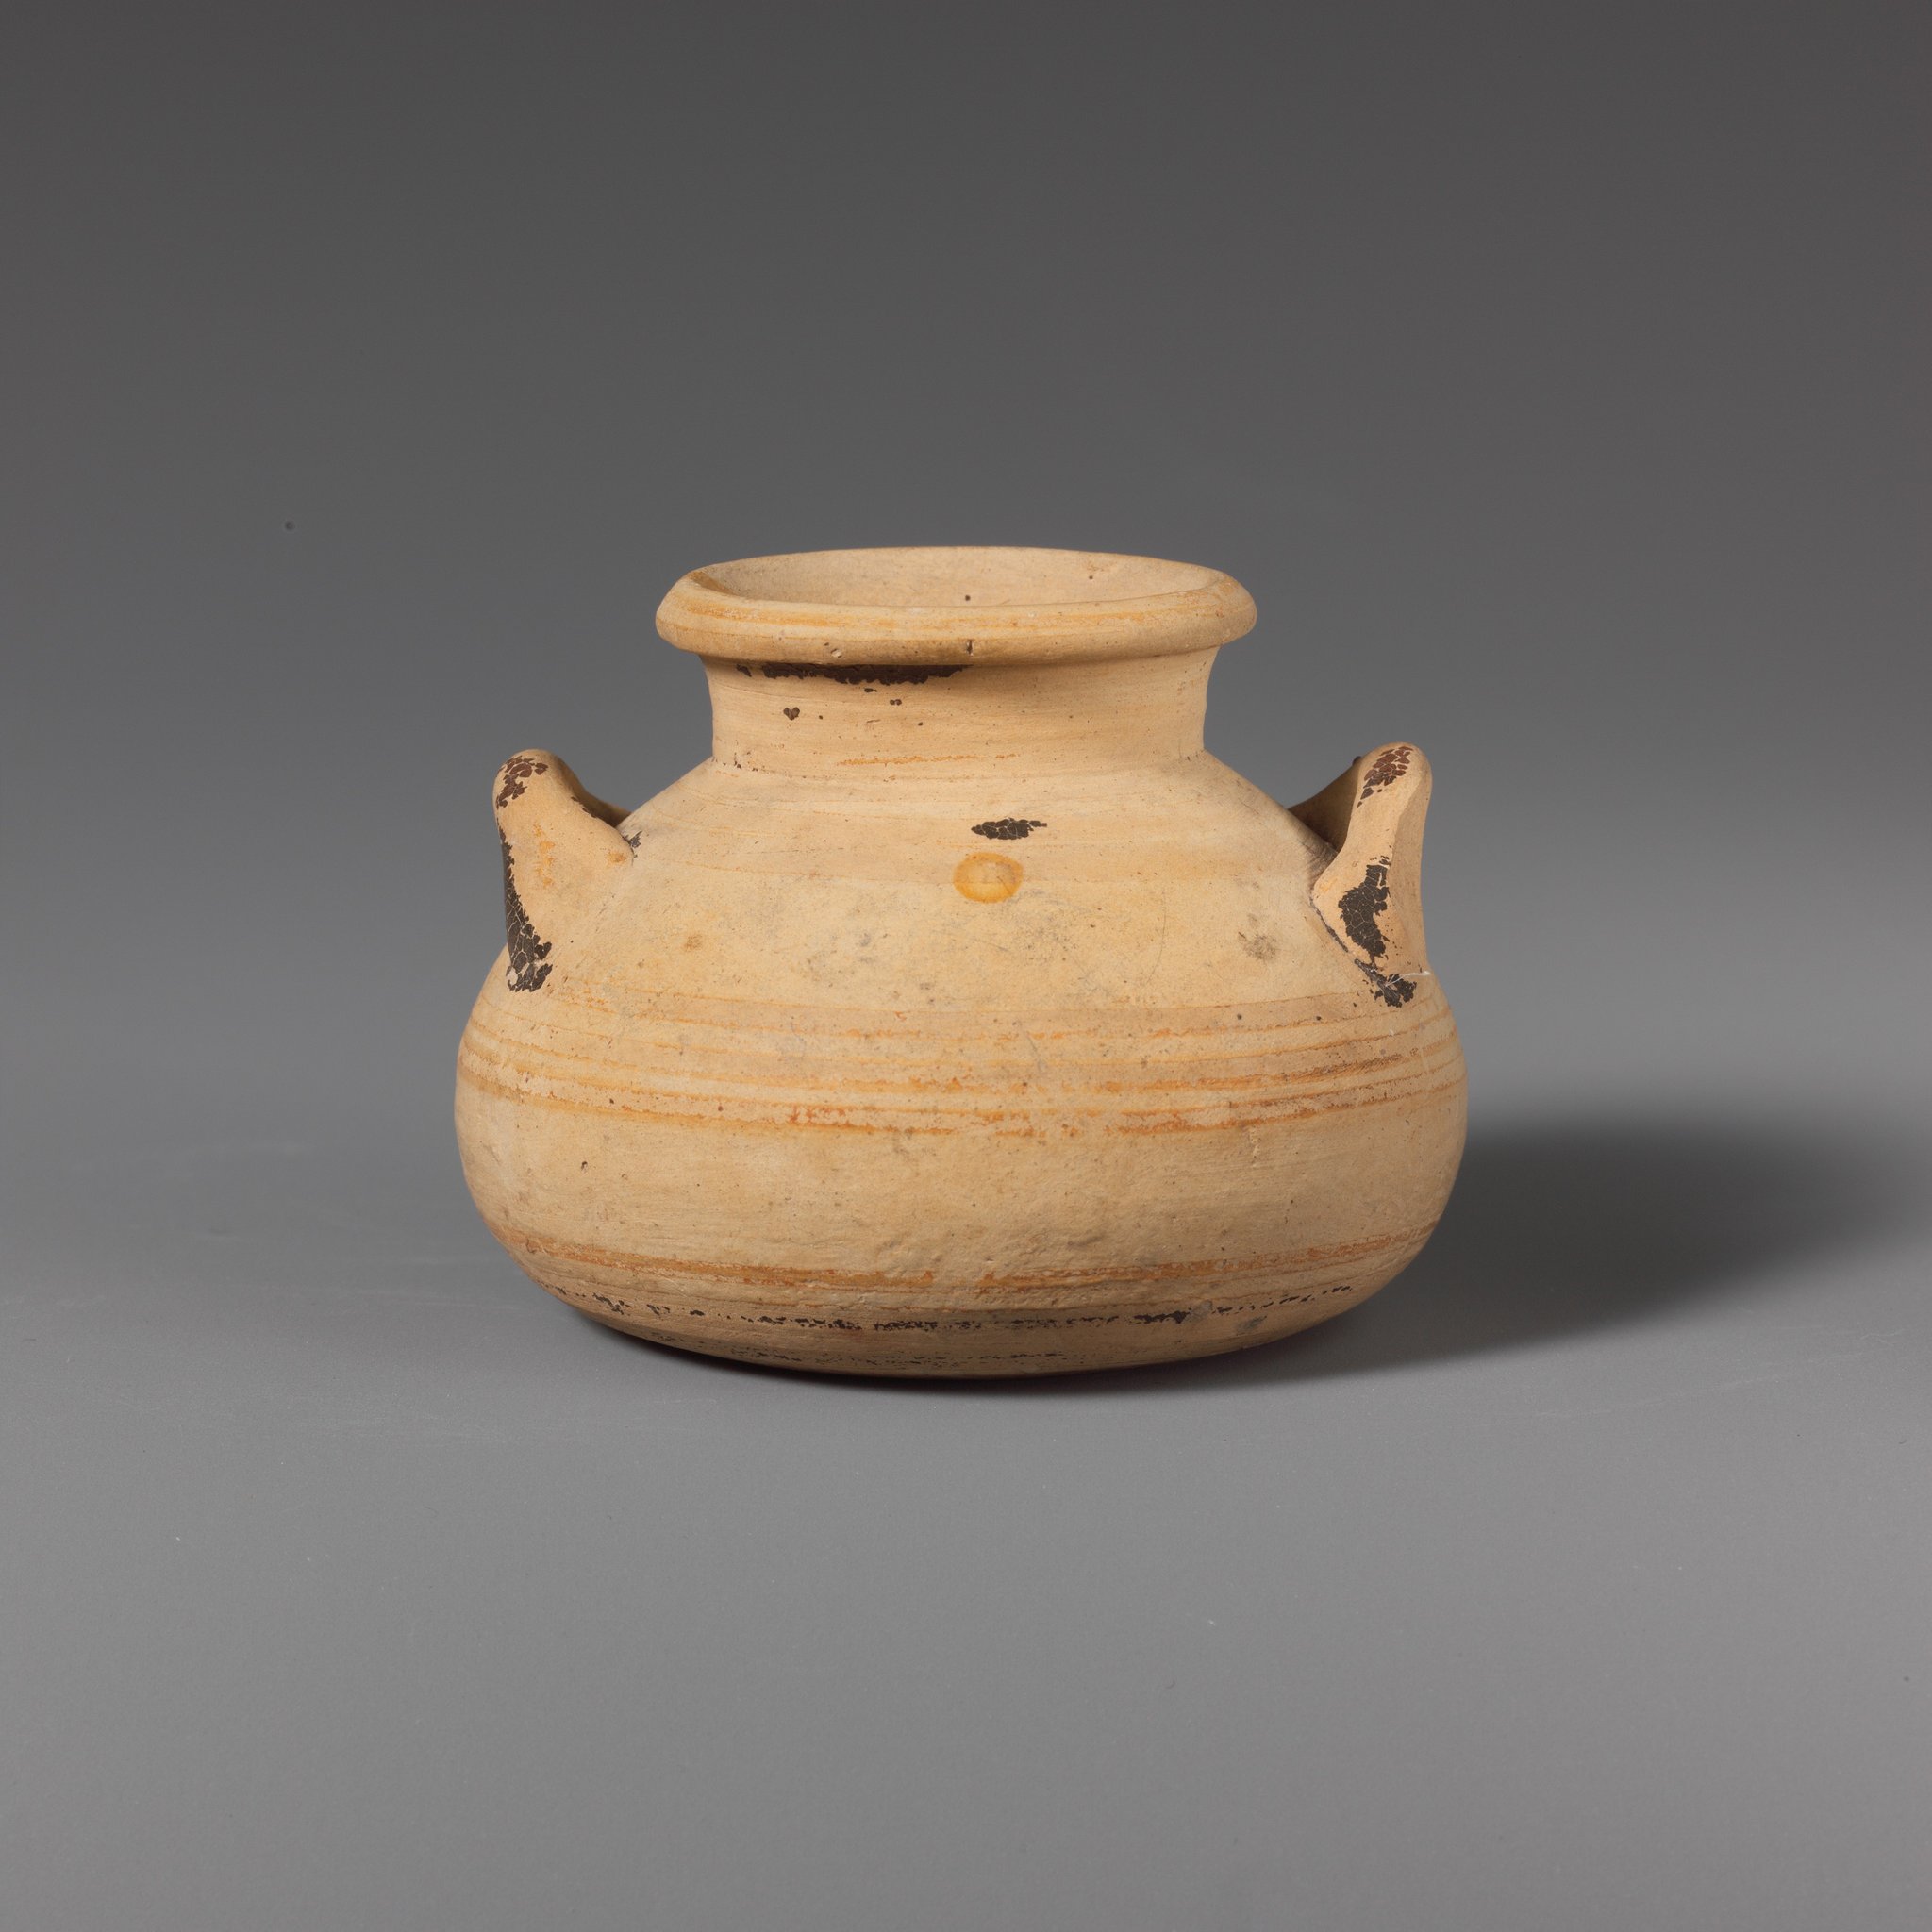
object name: vase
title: Terracotta alabastron (jar)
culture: mycenaean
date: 1600-1050 BCE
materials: terracotta